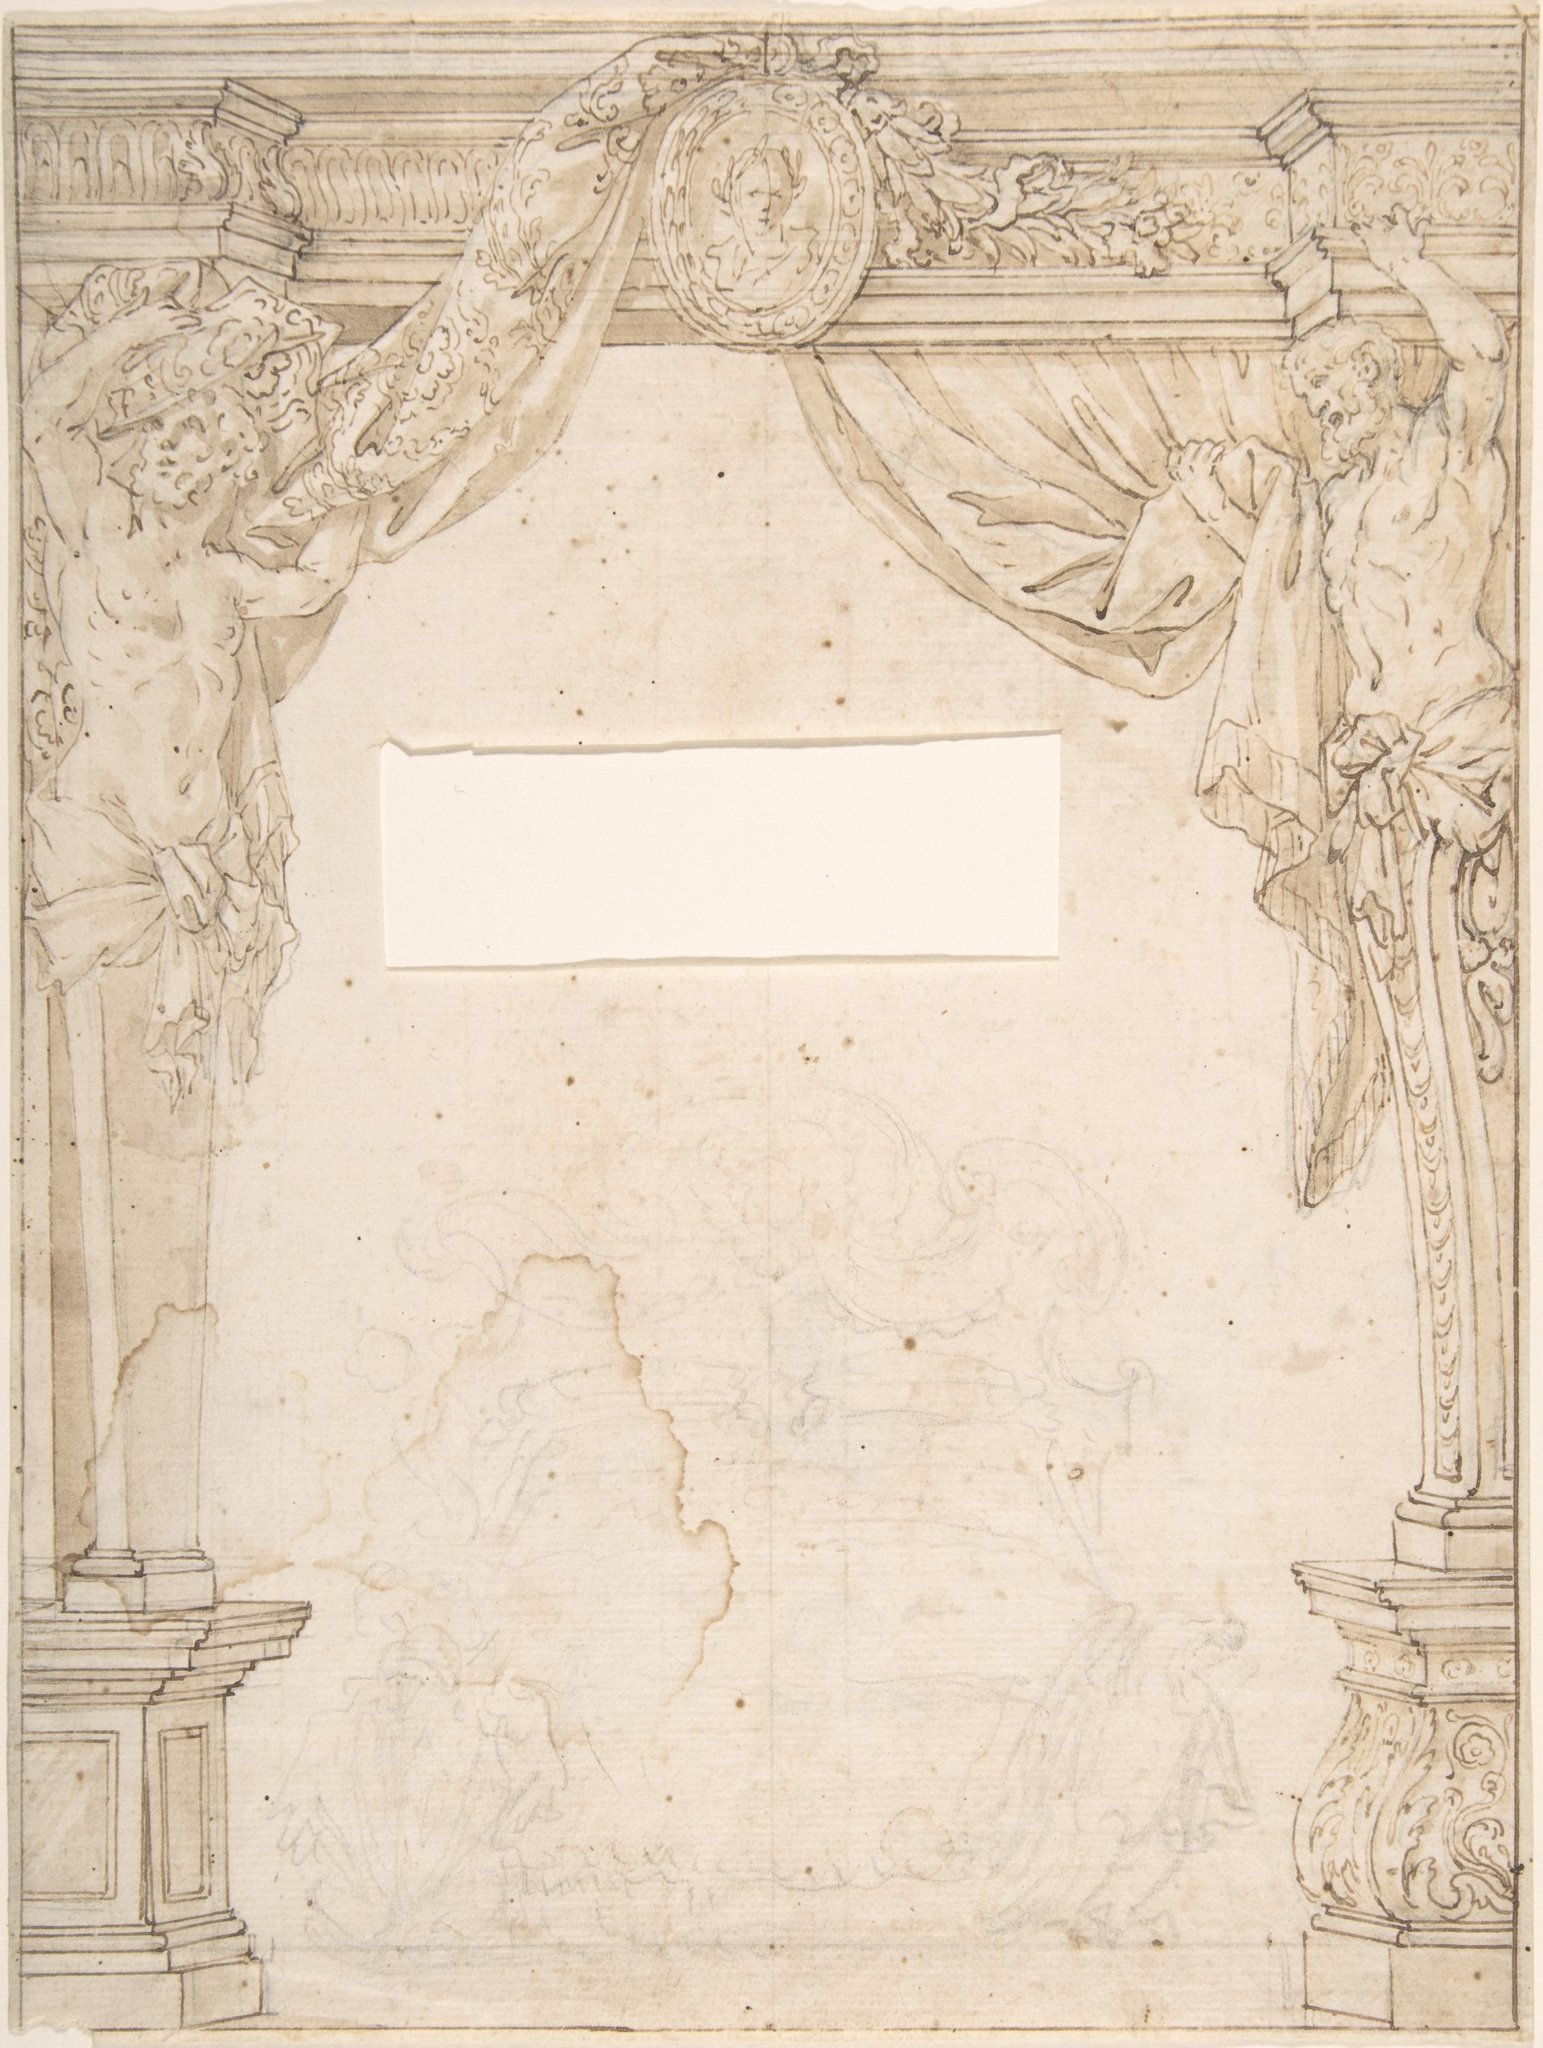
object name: drawing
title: Herms Supporting and Overdoor with Portrait Oval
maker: anonymous, italian, 17th century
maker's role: artist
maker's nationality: italian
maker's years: 1600-1700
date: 1601-1700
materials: graphite, ink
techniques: brush, pen, drawing, wash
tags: human figures,caryatids,portraits